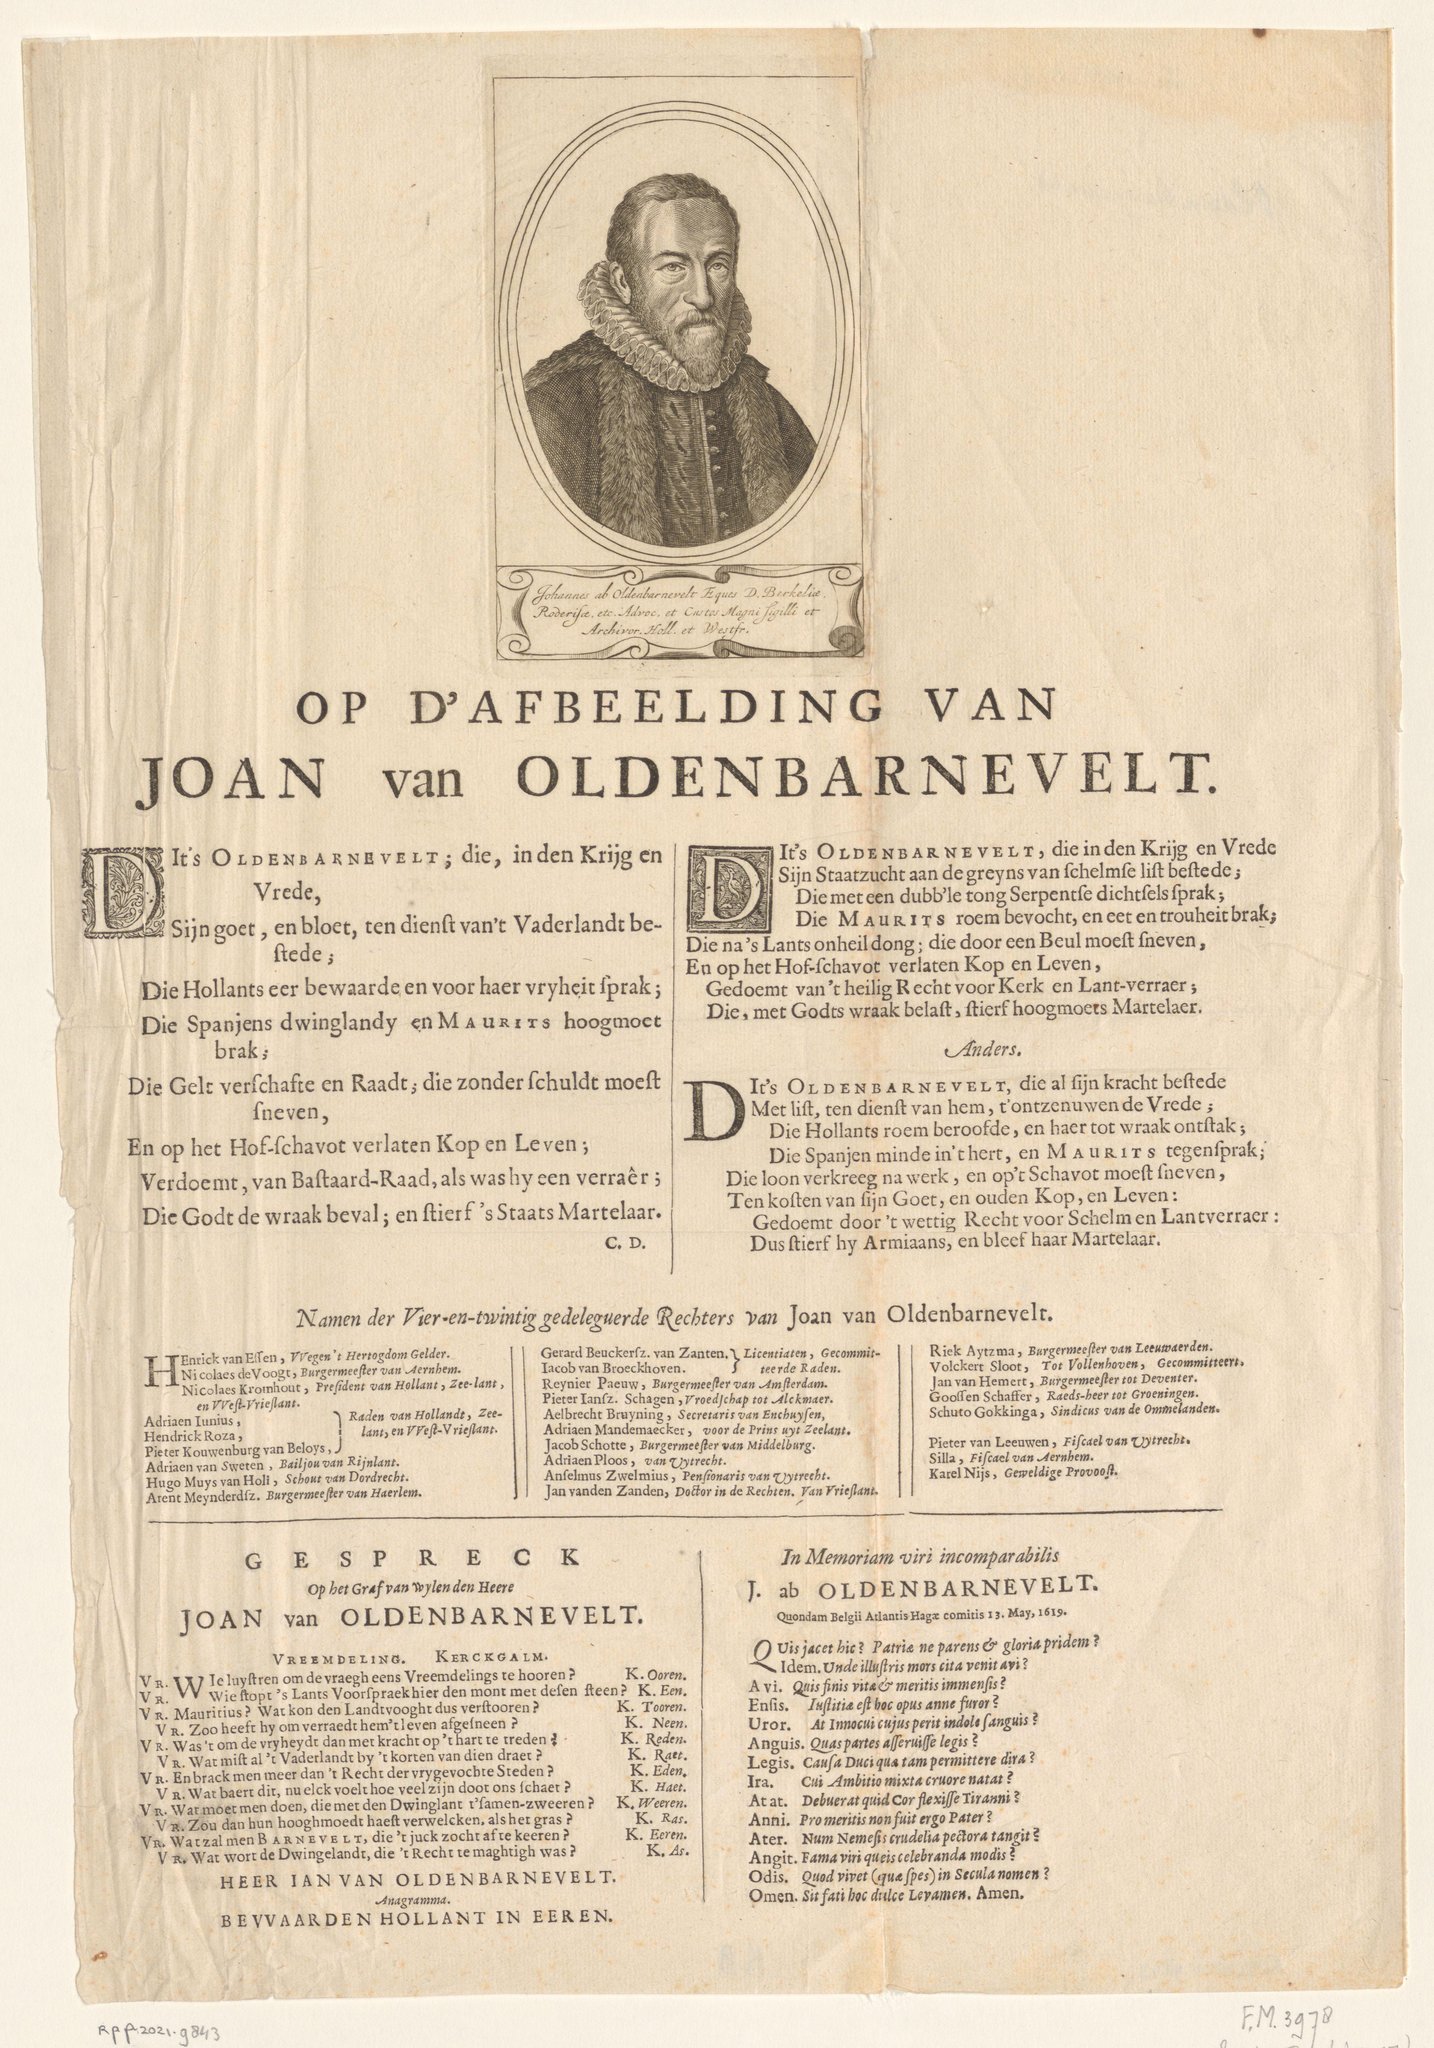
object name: print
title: Op D'Afbeelding van Joan van Oldenbarnevelt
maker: Anonymous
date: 1619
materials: paper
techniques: engraving, letterpress printing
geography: northern netherlands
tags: the hague, johan van oldenbarnevelt, adult man, historical persons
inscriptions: collector's mark: Lugt 2228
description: Blad met bovenaan een portret van Johan van Oldenbarnevelt, met een Latijns onderschrift in cartouche. Daaronder twee kolommen met drie verzen over de afbeelding van Van Oldenbarnevelt. Het linker vers prijst de landsadvocaat; de twee verzen rechts zijn bijna identiek verwoord maar hebben een tegenovergestelde strekking. Onder de verzen staan de namen van de vierentwintig rechters die hem ter dood hebben veroordeeld in februari 1619.